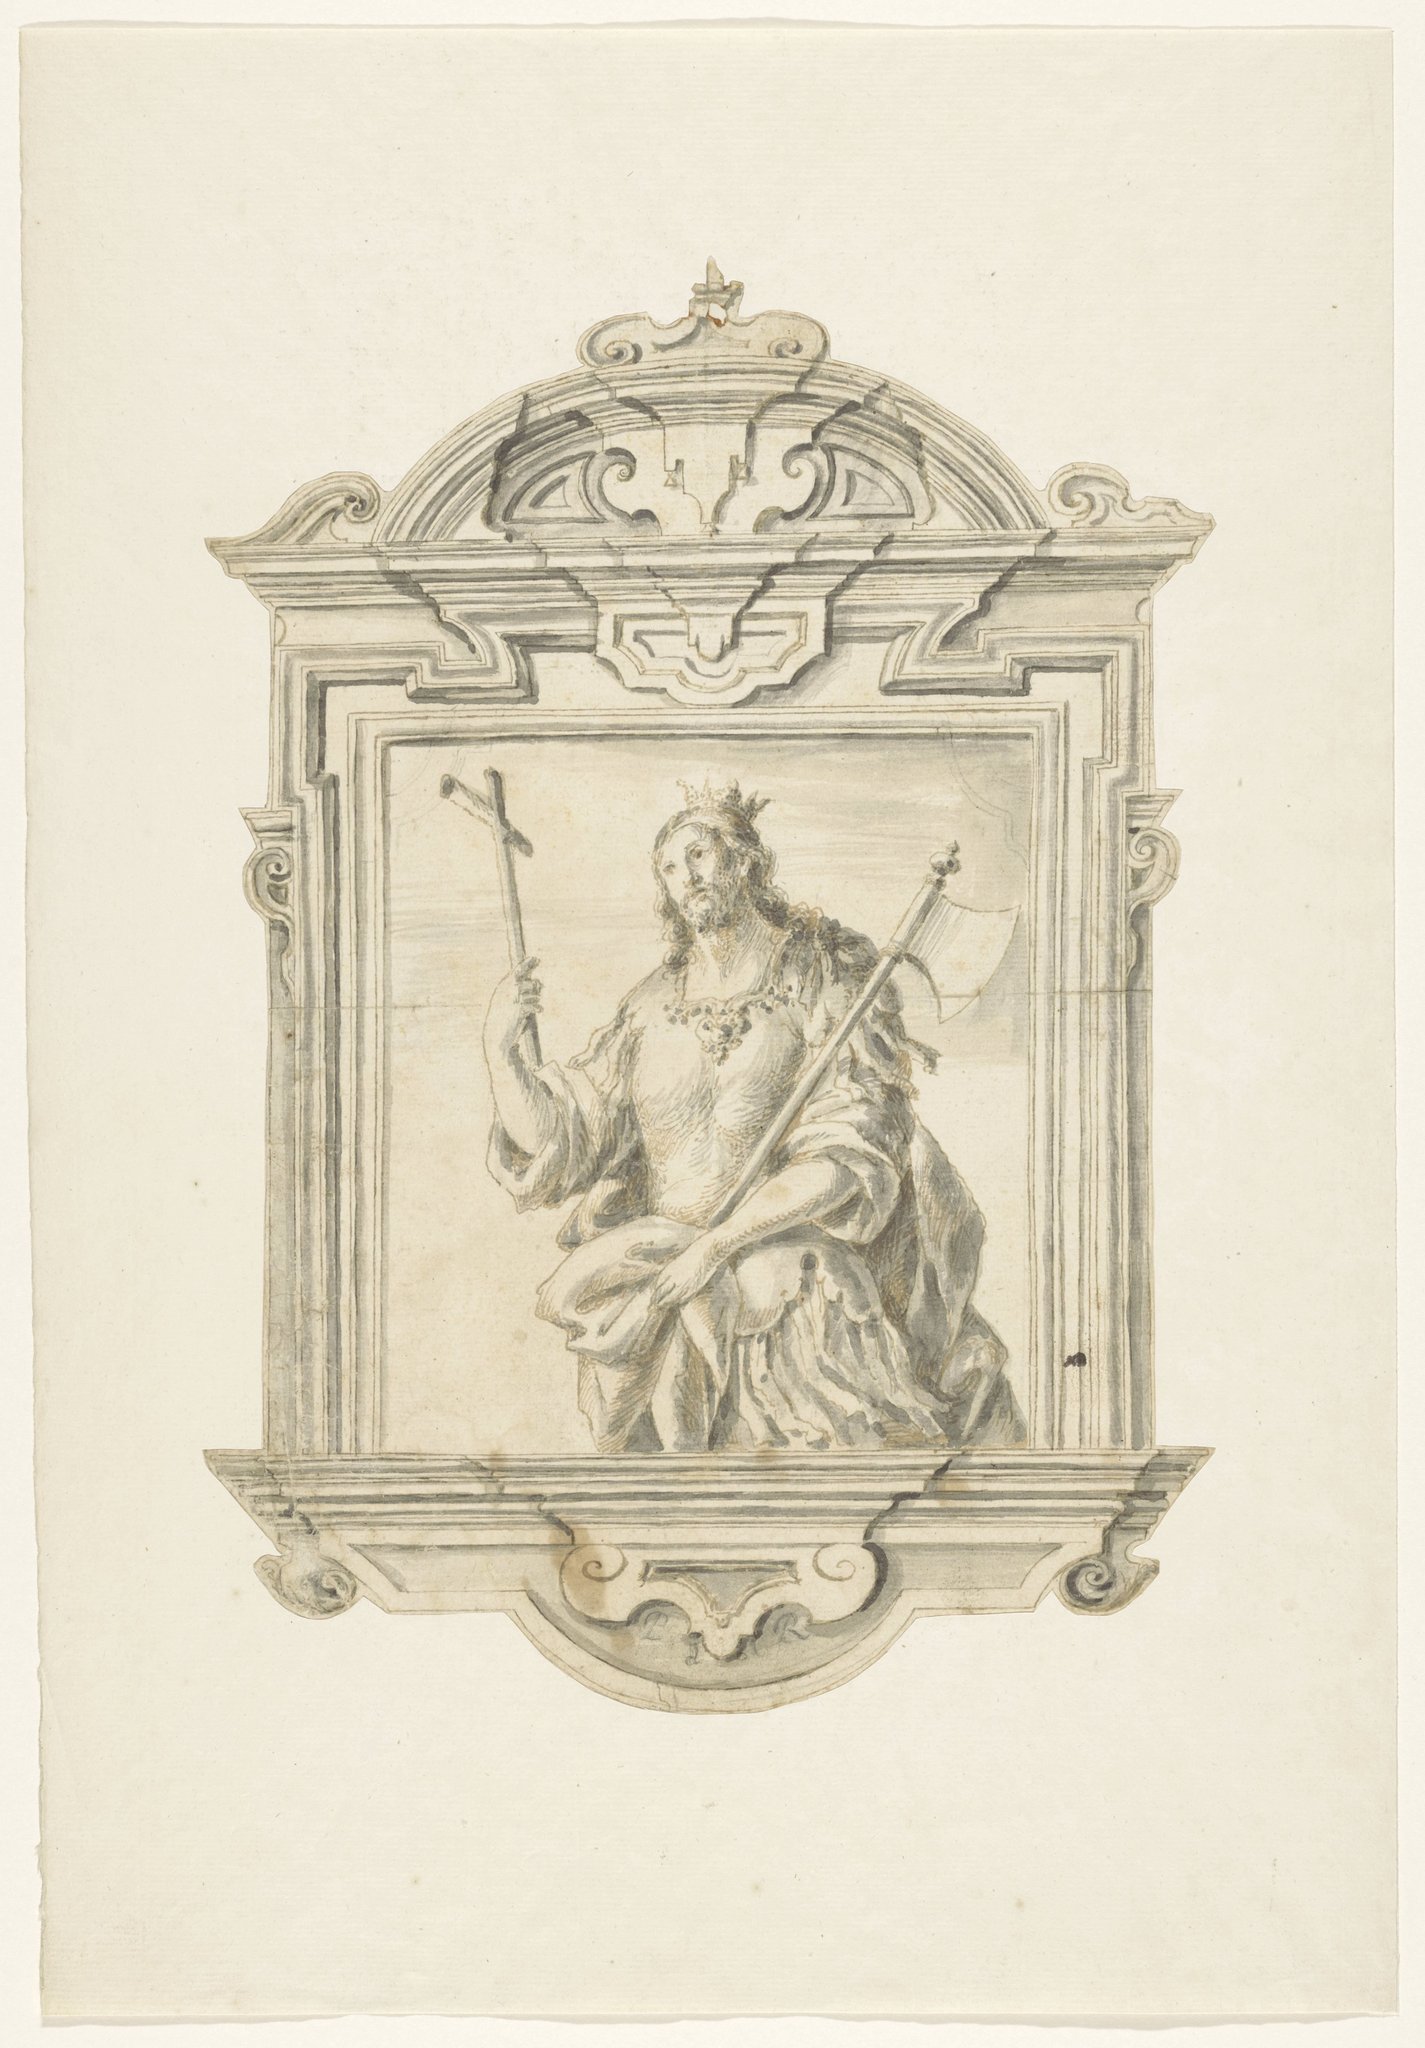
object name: drawing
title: Barokke lijst met voorstelling van een martelaar in kniestuk, met een kruis en bijl in de hand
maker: Anonymous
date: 1600-1699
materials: ink, paper, pencil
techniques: brush, pen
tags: saints, picture, painting